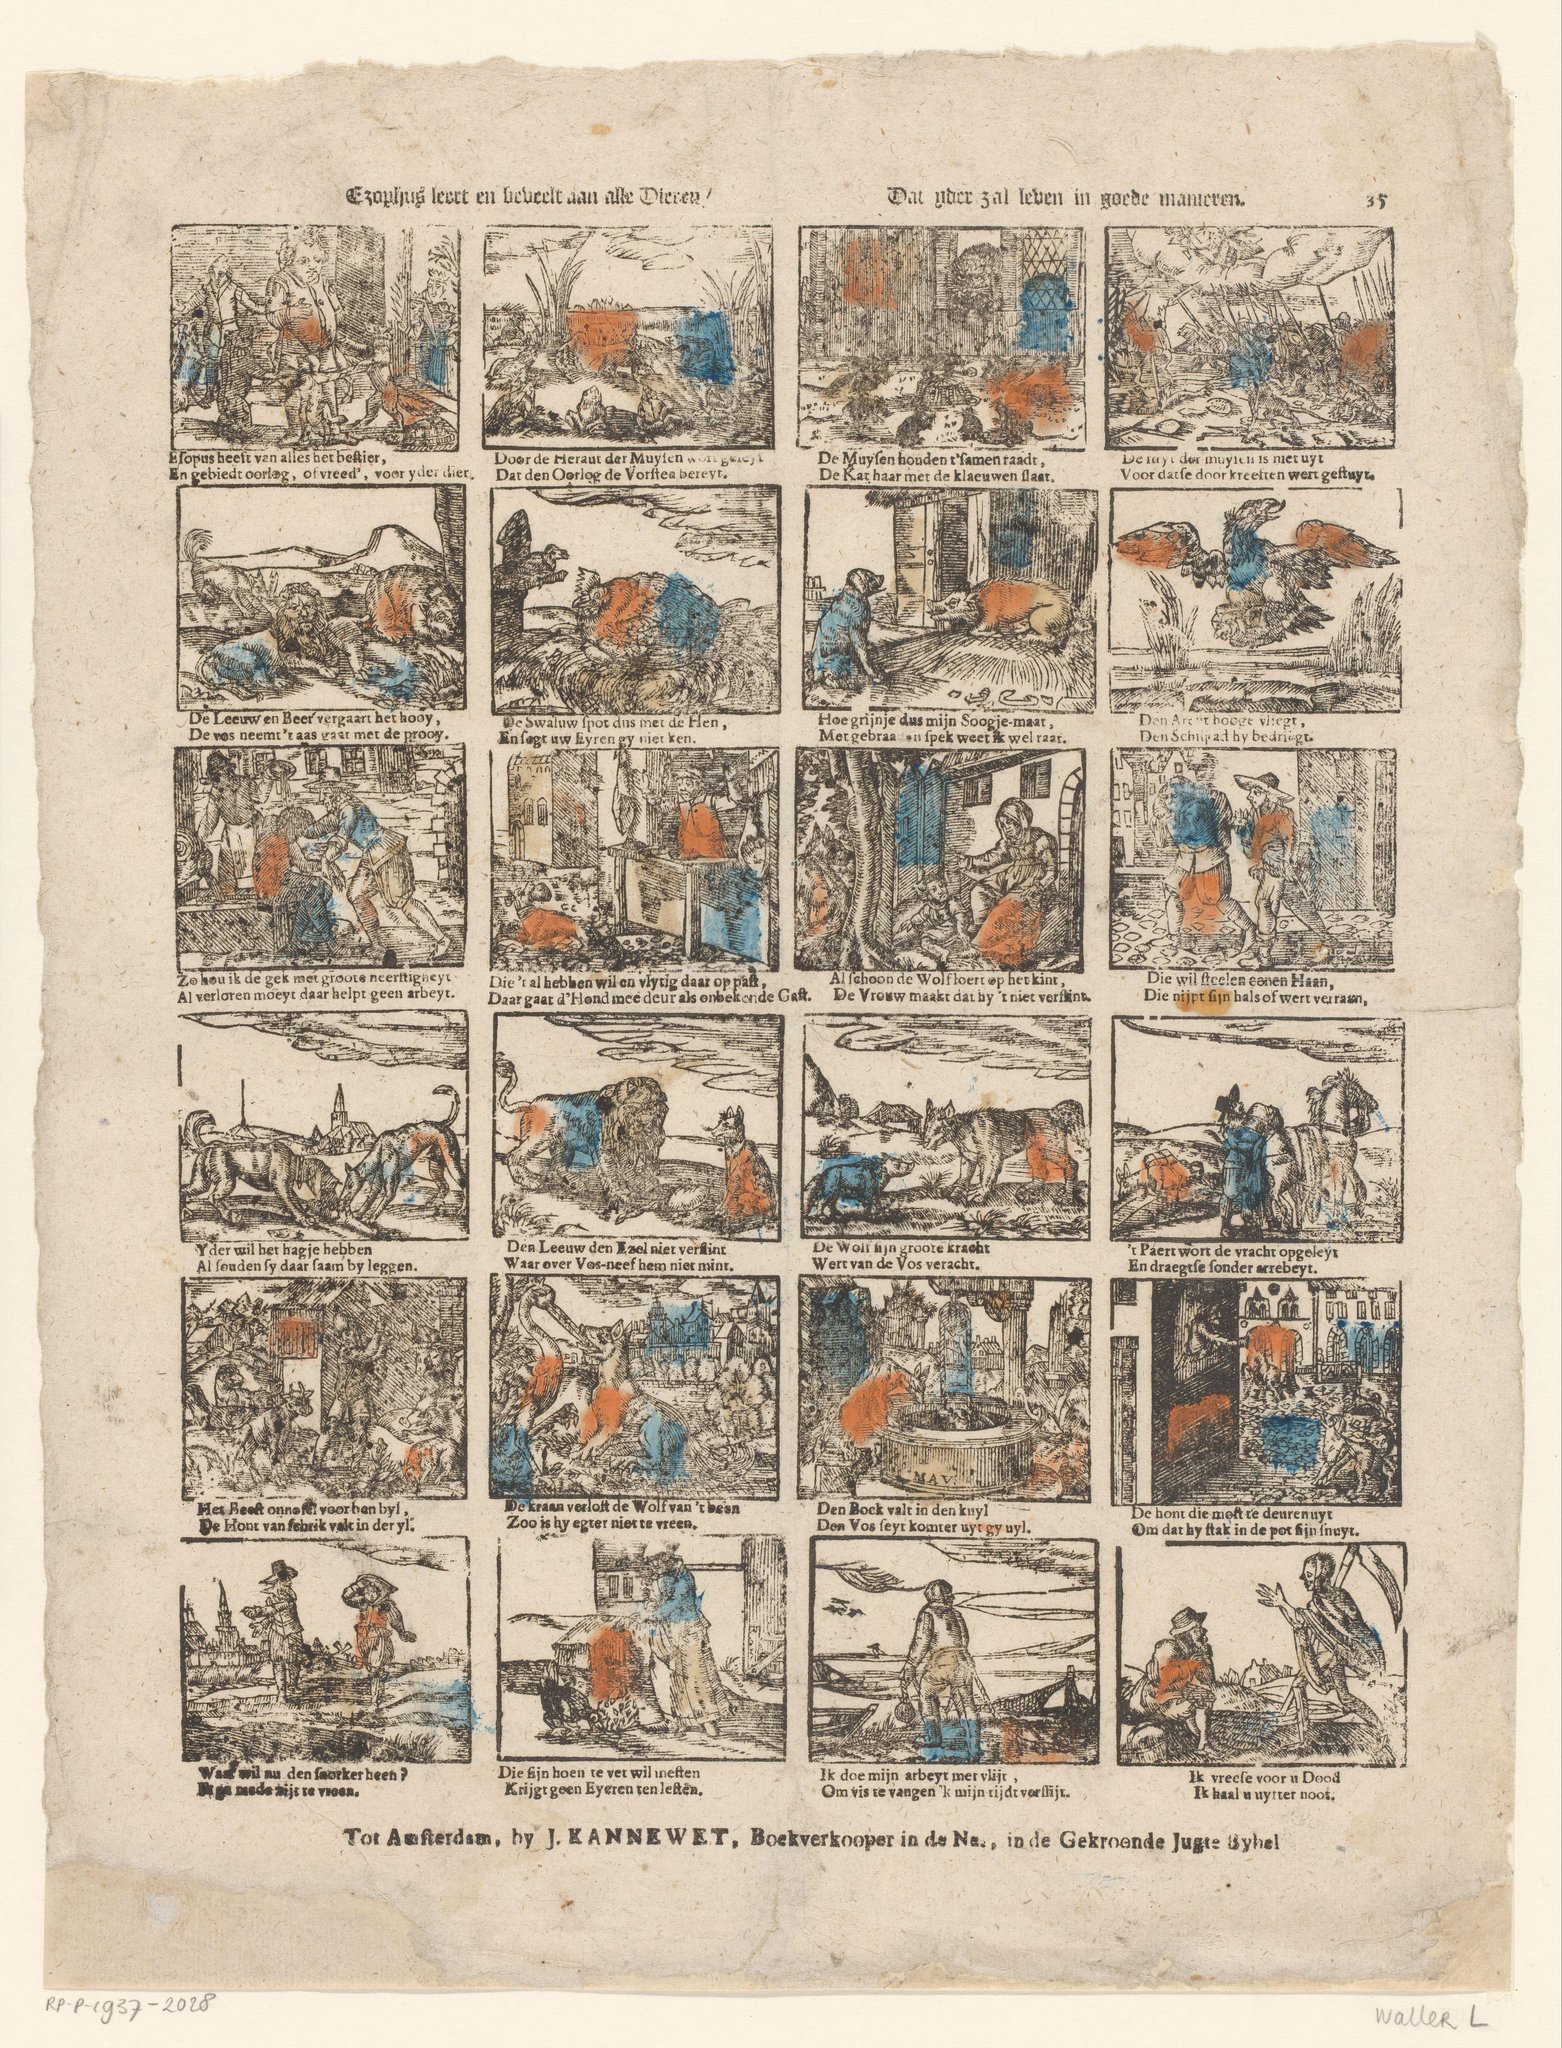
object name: print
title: Ezophus leert en beveelt aan alle dieren / Dat yder zal leven in goede manieren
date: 1725-1780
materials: paper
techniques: colour, letterpress printing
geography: netherlands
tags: animals, fables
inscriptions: collector's mark: Lugt 2228, collector's mark: Lugt 2760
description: Blad met 24 voorstellingen uit de fabelen van Aesopus. Onder elke afbeelding een tweergelig vers. Genummerd rechtsboven: 35.